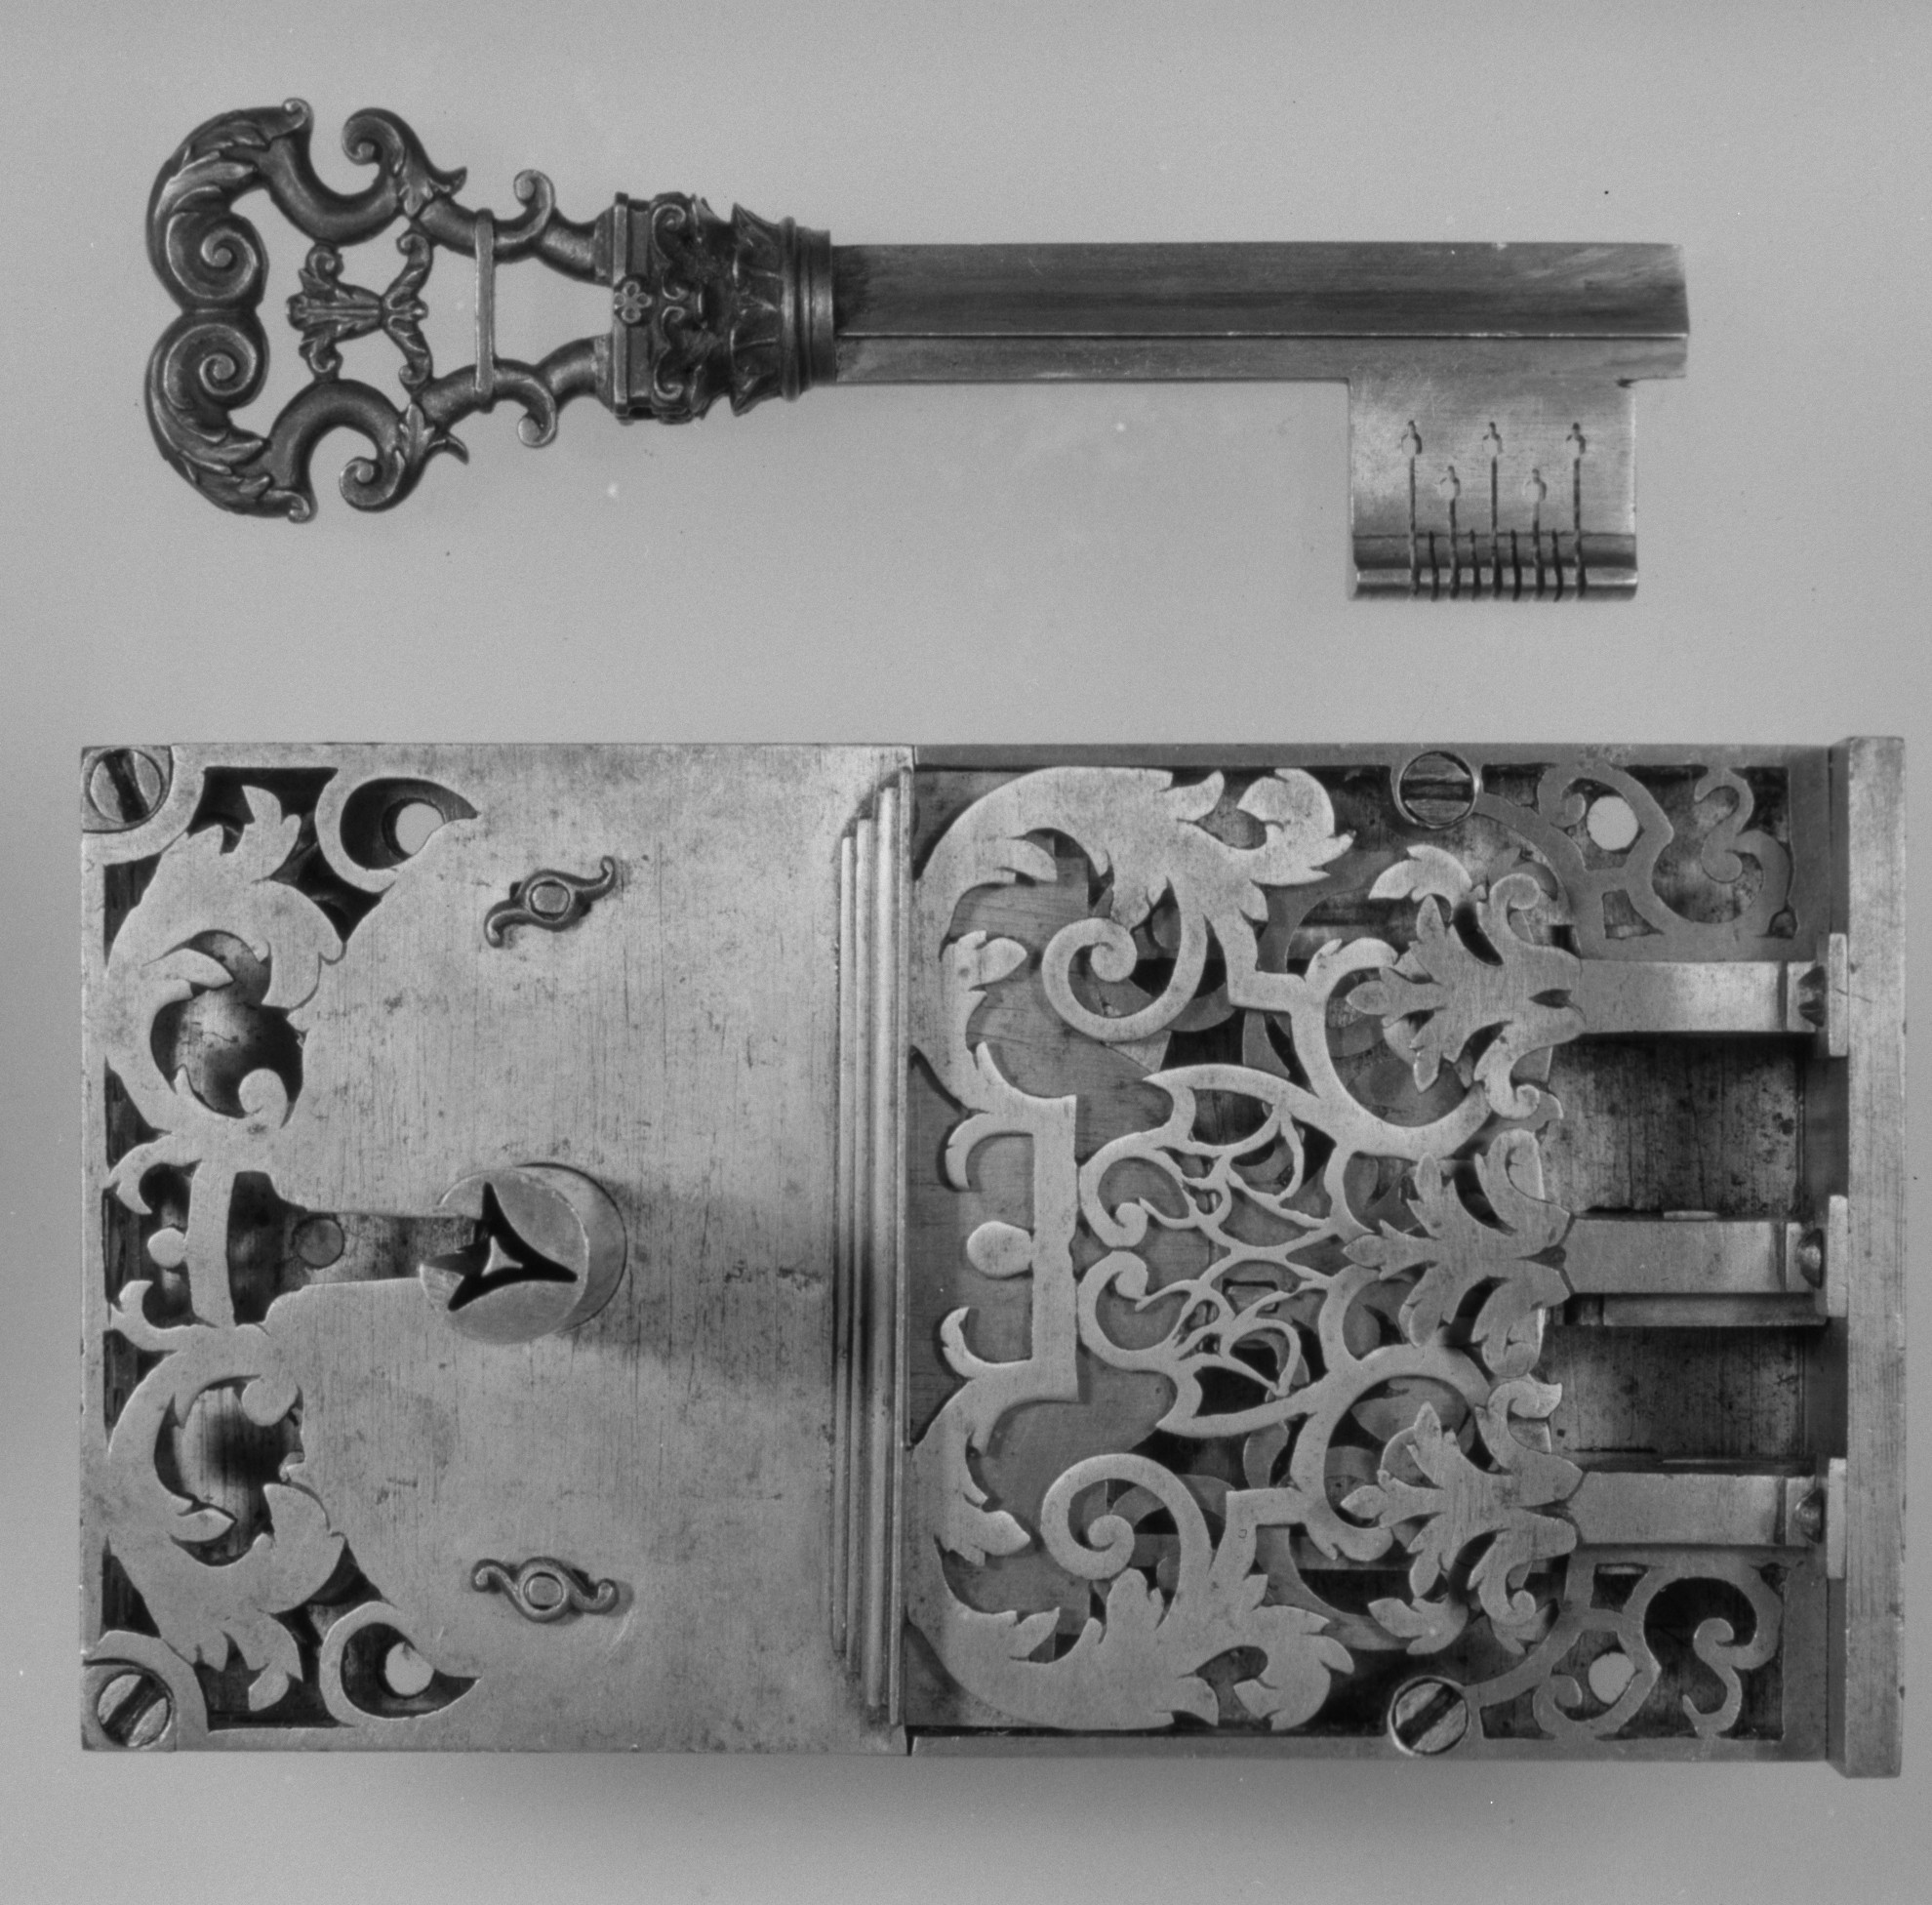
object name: coffer lock and key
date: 1680-1700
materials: iron, steel